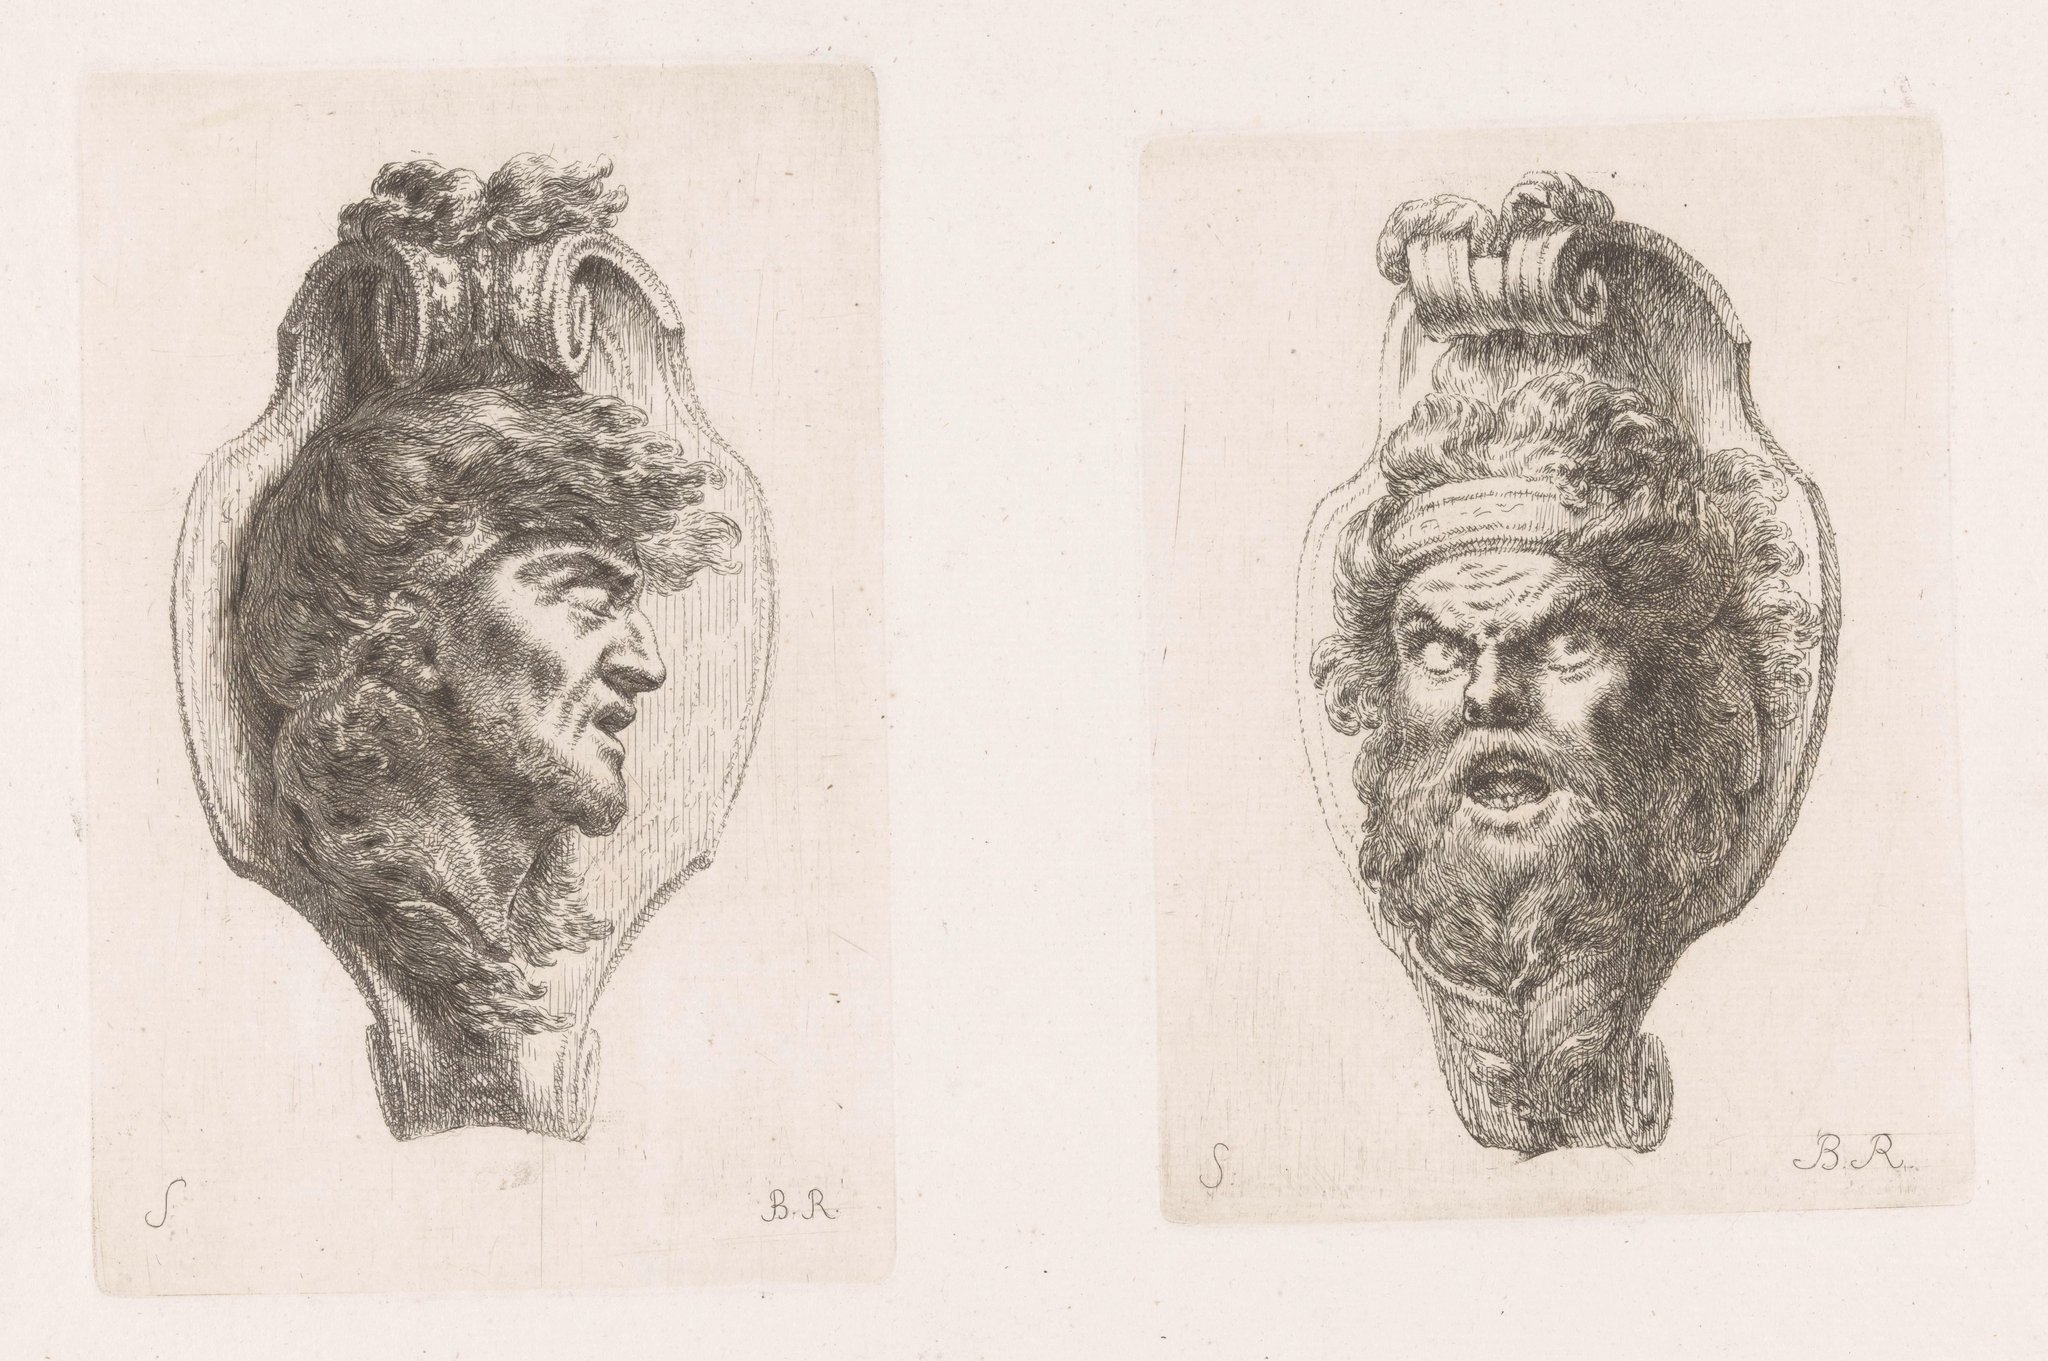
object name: ornament print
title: Mascarons en helmen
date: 1759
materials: paper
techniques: etching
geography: berlin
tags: mask, mascaron ~ ornament, the soldier; the soldier's life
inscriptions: collector's mark: Lugt 2760, collector's mark: Lugt 2228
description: Prent is gemaakt naar de sculpturen van Andreas Schlüter in het Zeughaus (tegenwoordig het Deutsches Historisches Museum) te Berlijn. Mogelijk prent uit: Rode, Bernhard. Larven nach den Modelen des berühmten Schlüters gezeichnet und in Kupfer geätzt von B. Rode. Berlijn: Rode, Heinrich, 1759.